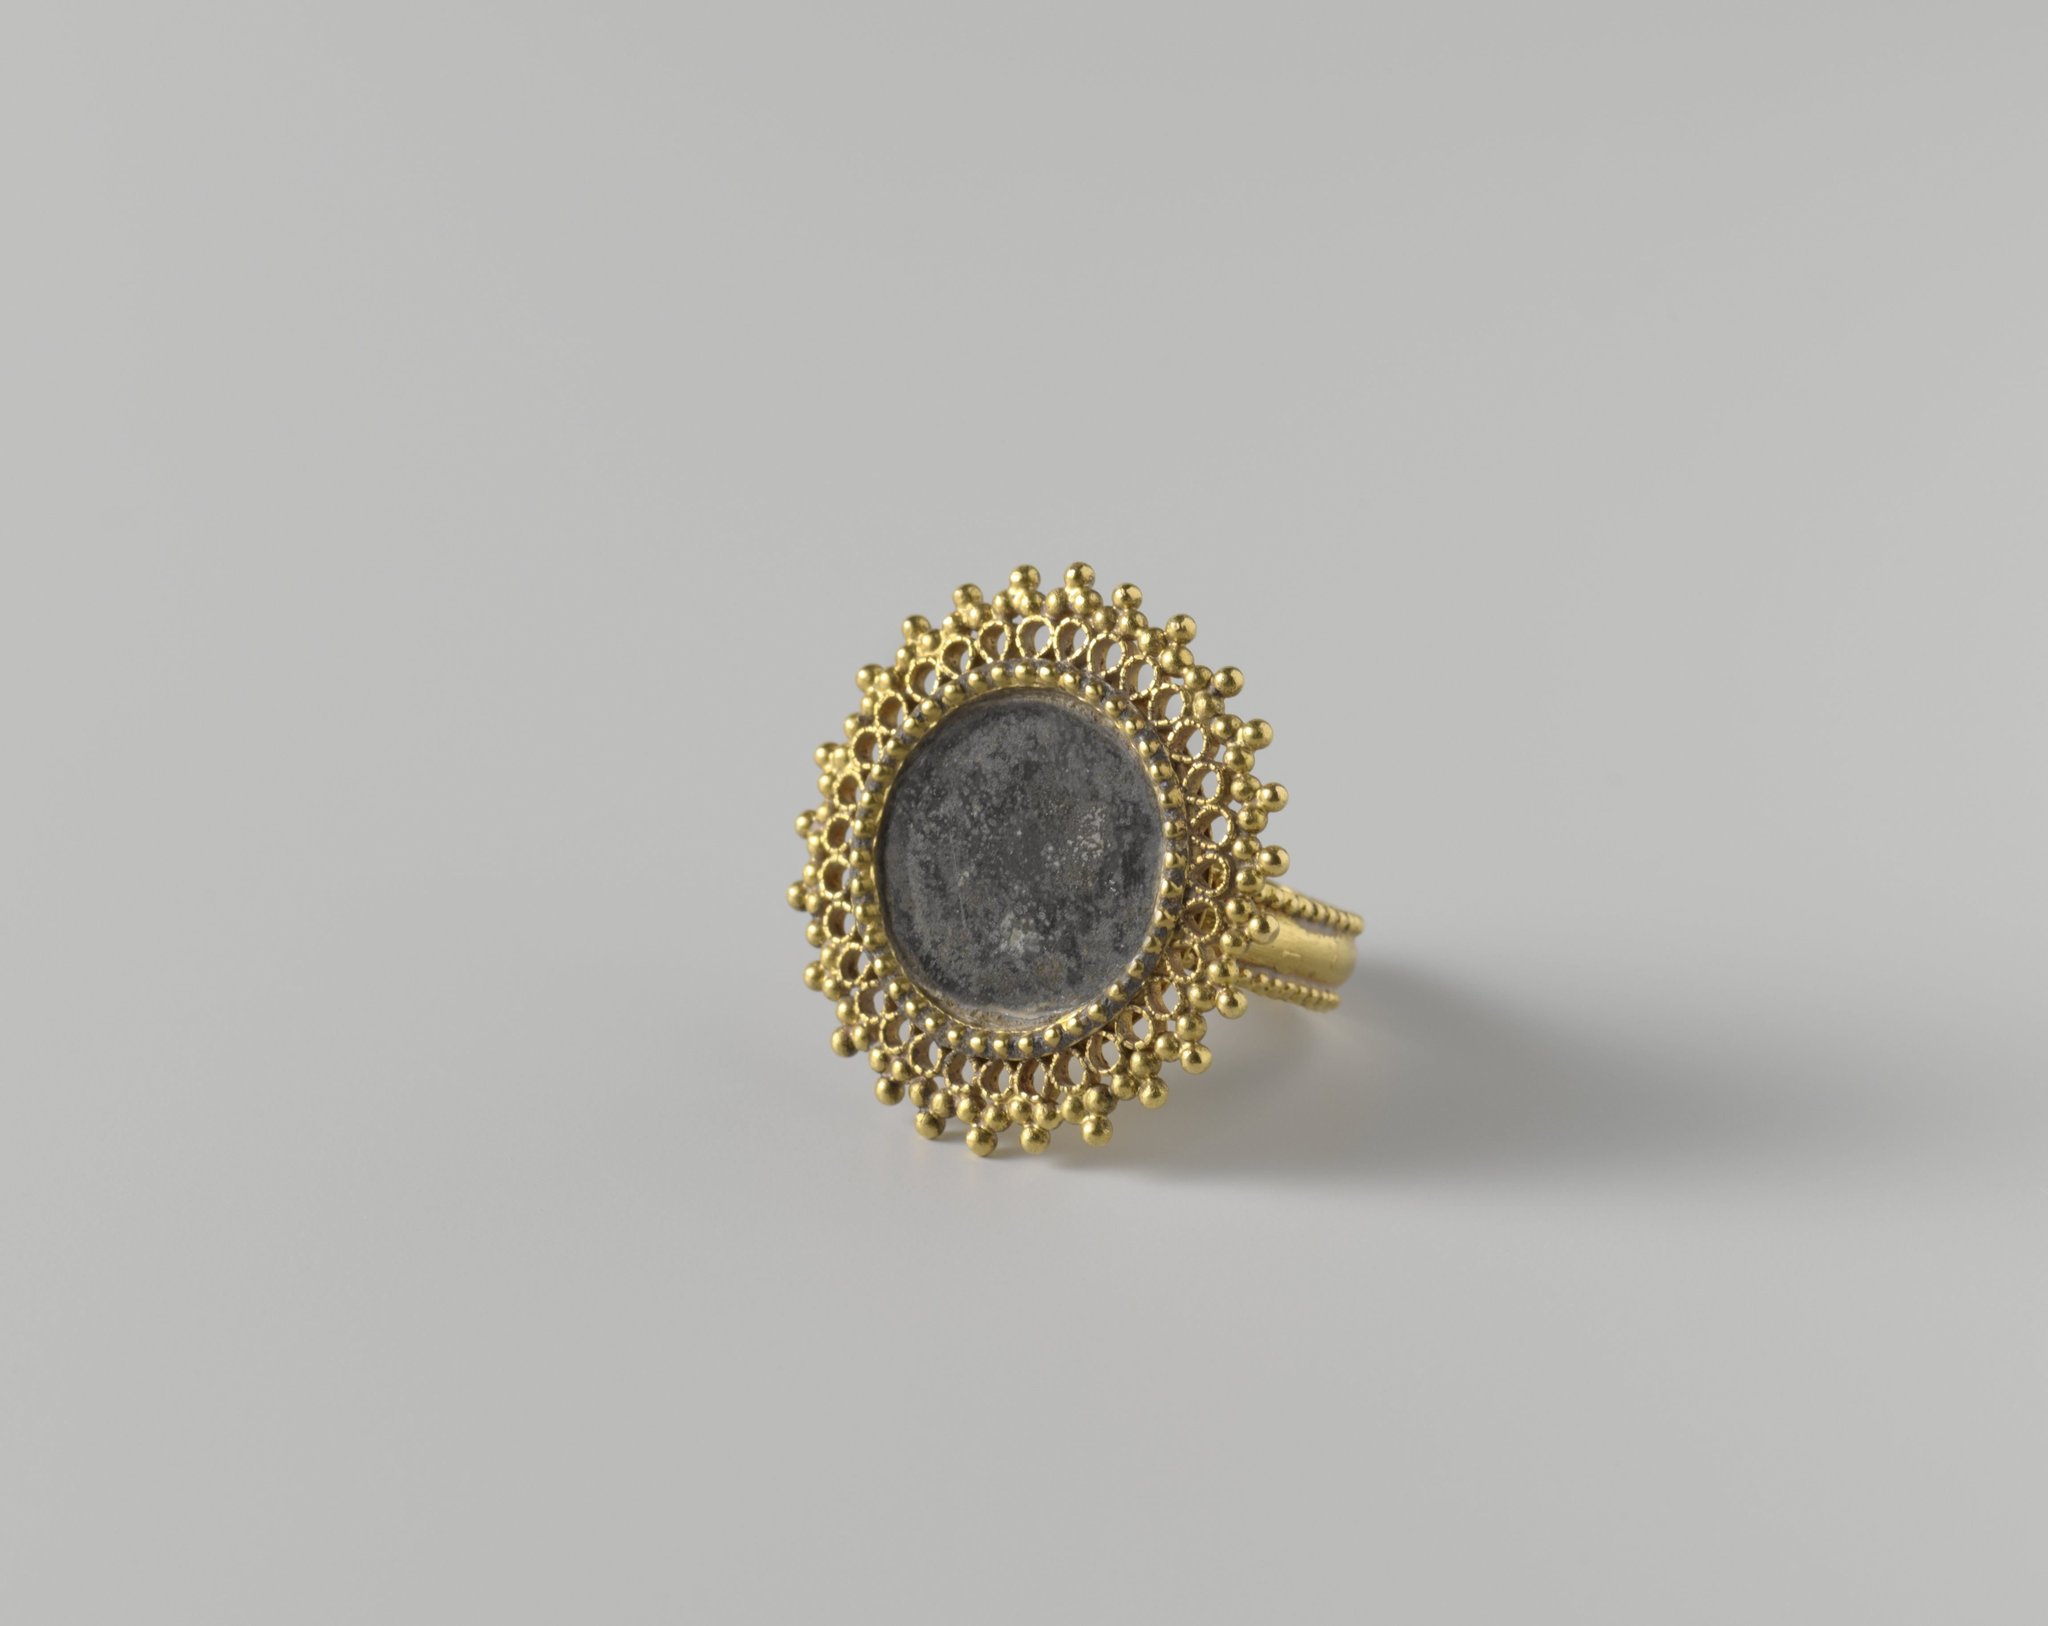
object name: duimring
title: Thumb ring (arsi)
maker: Anonymous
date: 1750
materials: gold, glass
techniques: filigree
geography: surat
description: Duimring (arsi) van goud met spiegel, gevat in filigrein appliqué.